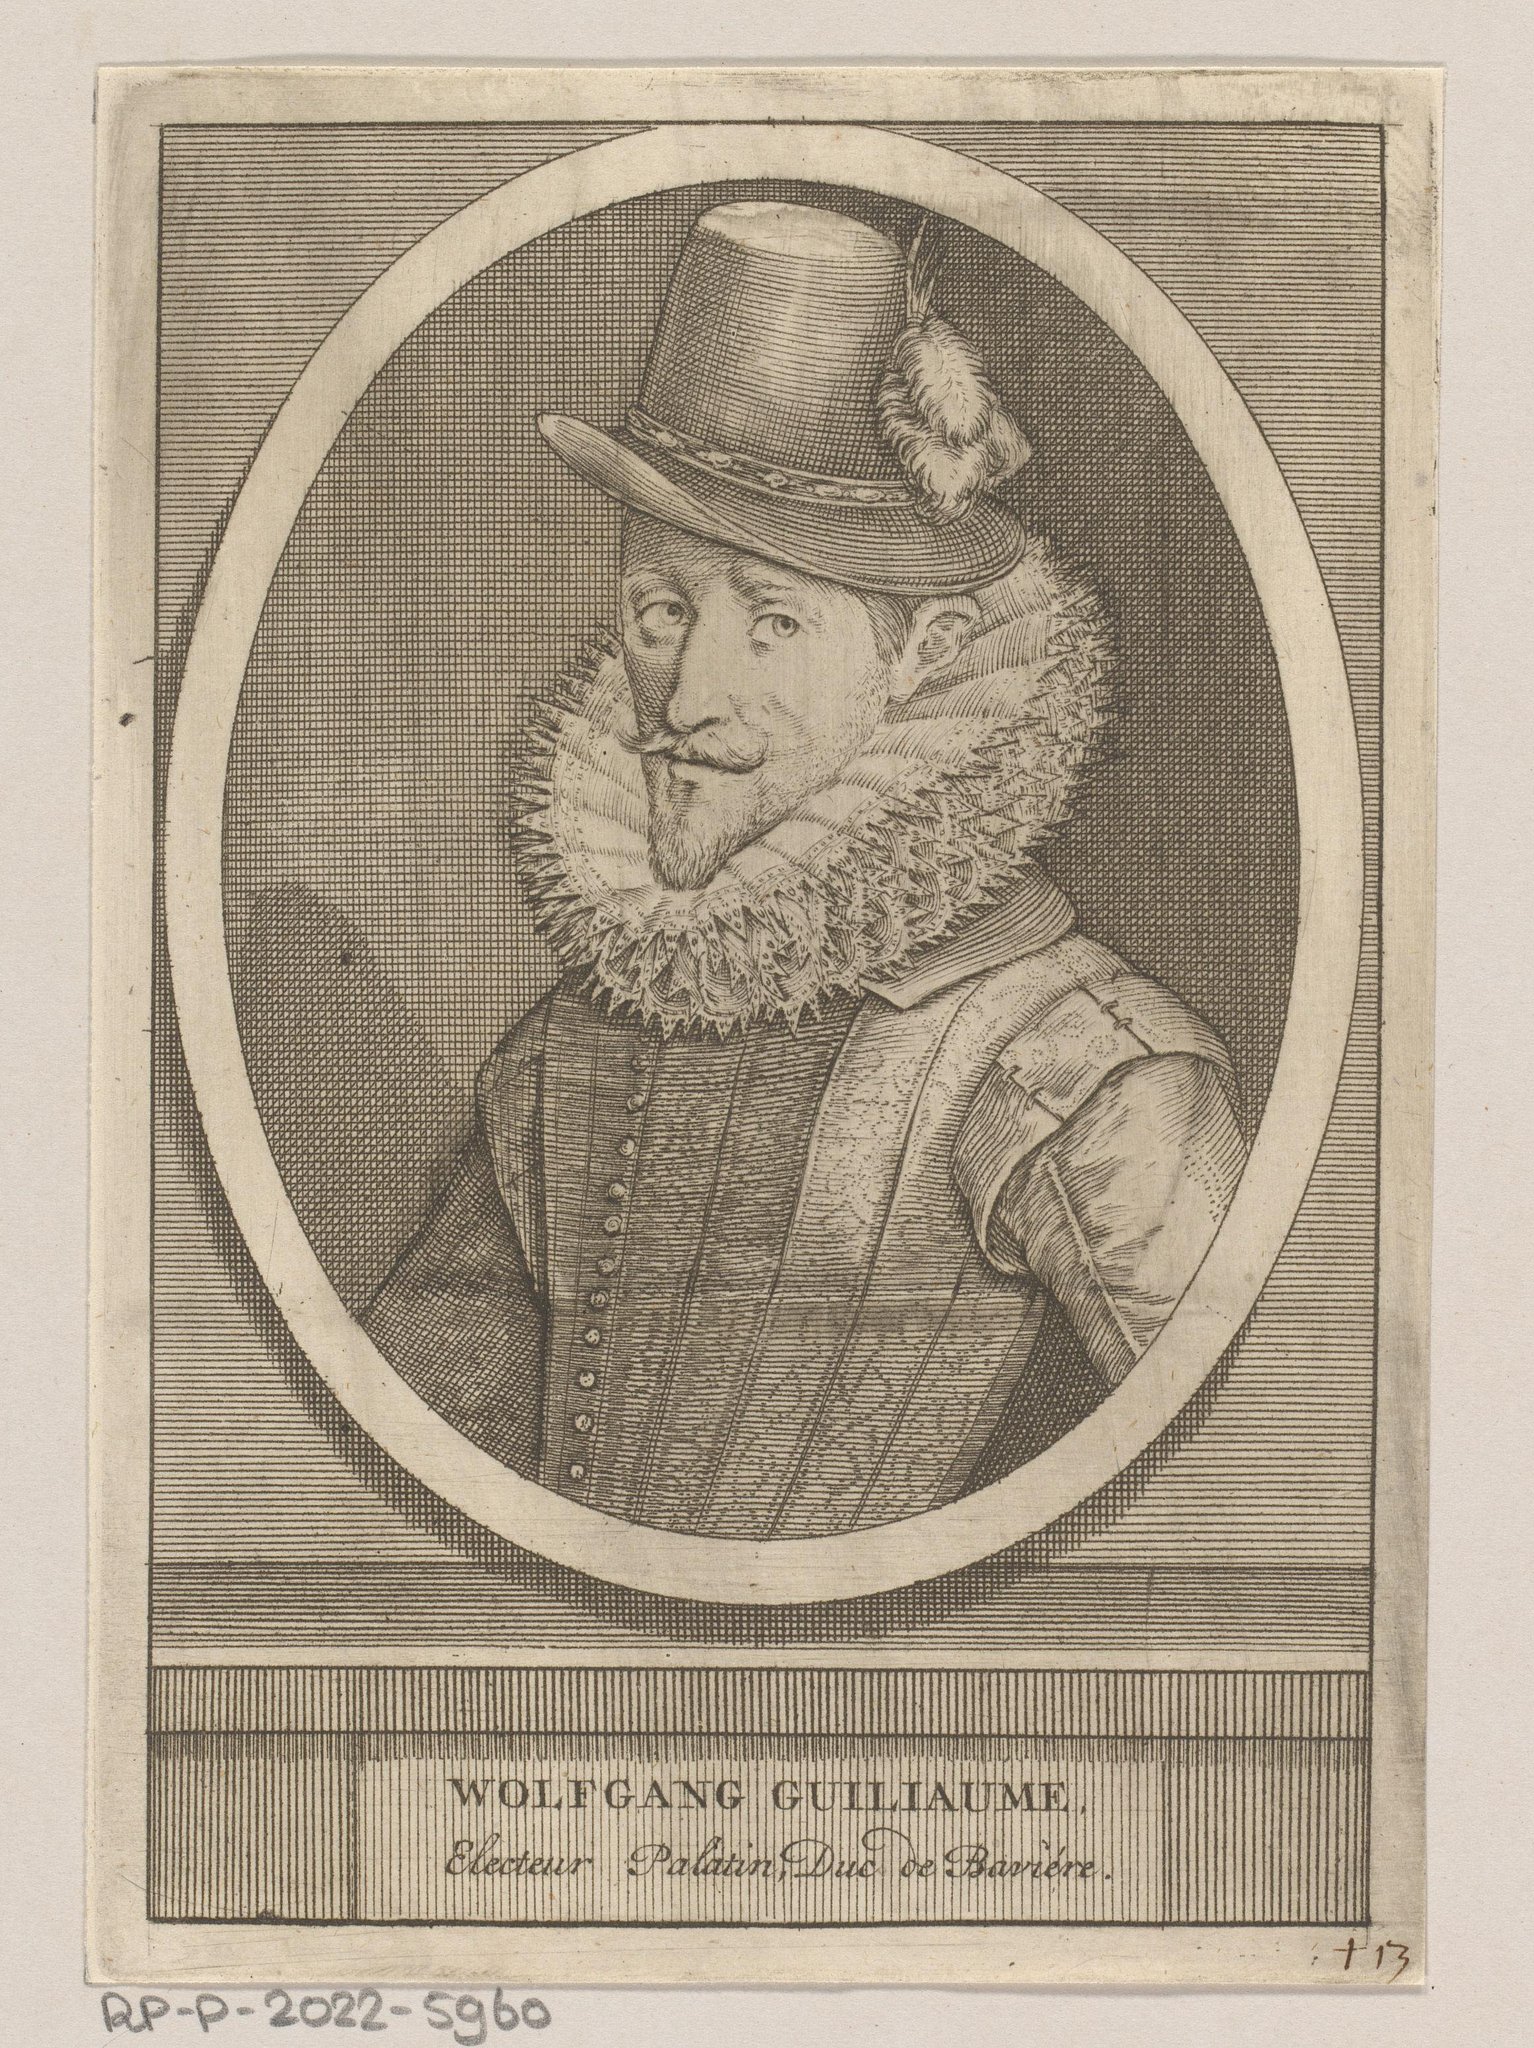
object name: print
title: Portretten van groothertogen, keurvorsten, aartshertogen en andere prinsen en prinsessen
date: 1715-1730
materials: paper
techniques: etching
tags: wolfgang willem van de palts-neuburg, historical persons, ruler, sovereign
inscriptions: number: ‘+13’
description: Mogelijk eerdere staat gebruikt in: Meteren, Emanuel van. Historien der Nederlanden en haar naburen oorlogen tot het Iaar 1612. Amsterdam: Jan Jacobsz. Schipper, 1663. Eerdere staat mogelijk ook gebruikt in andere edities van dit werk. In de huidige staat uitgegeven door Pieter van der Aa.